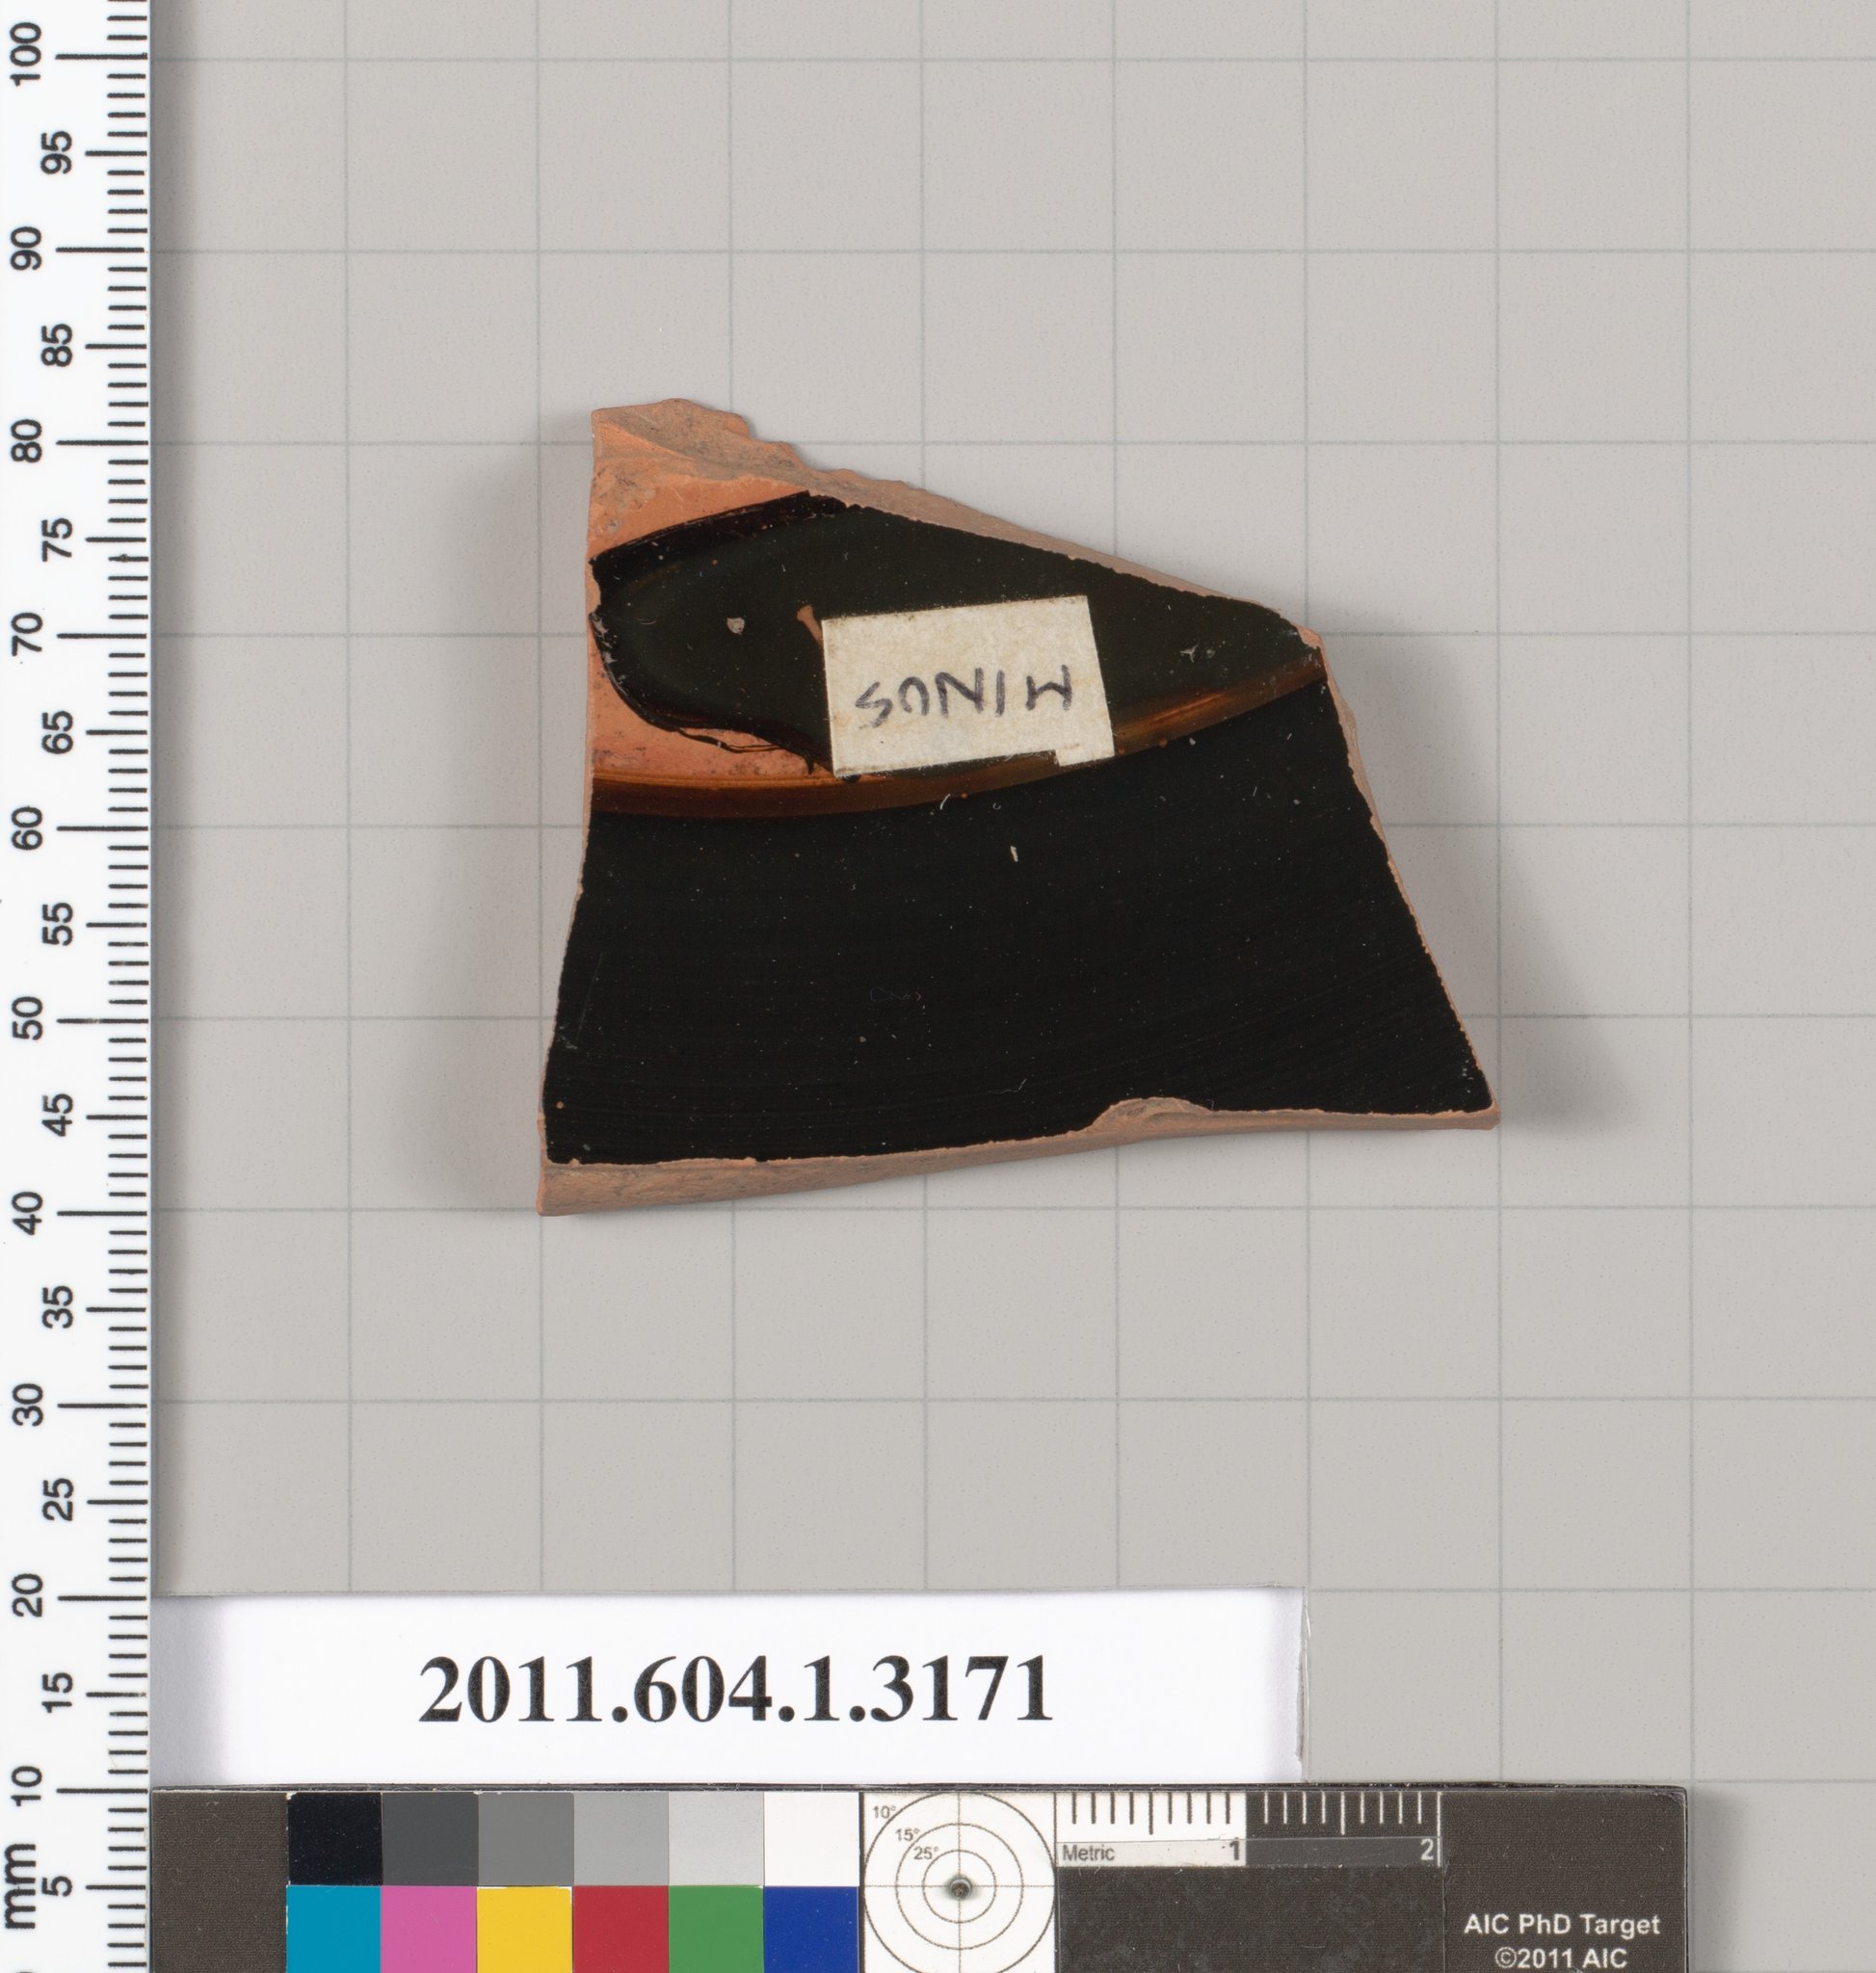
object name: kylix fragment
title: Terracotta fragment of a kylix (drinking cup)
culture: greek, attic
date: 510-490 BCE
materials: terracotta